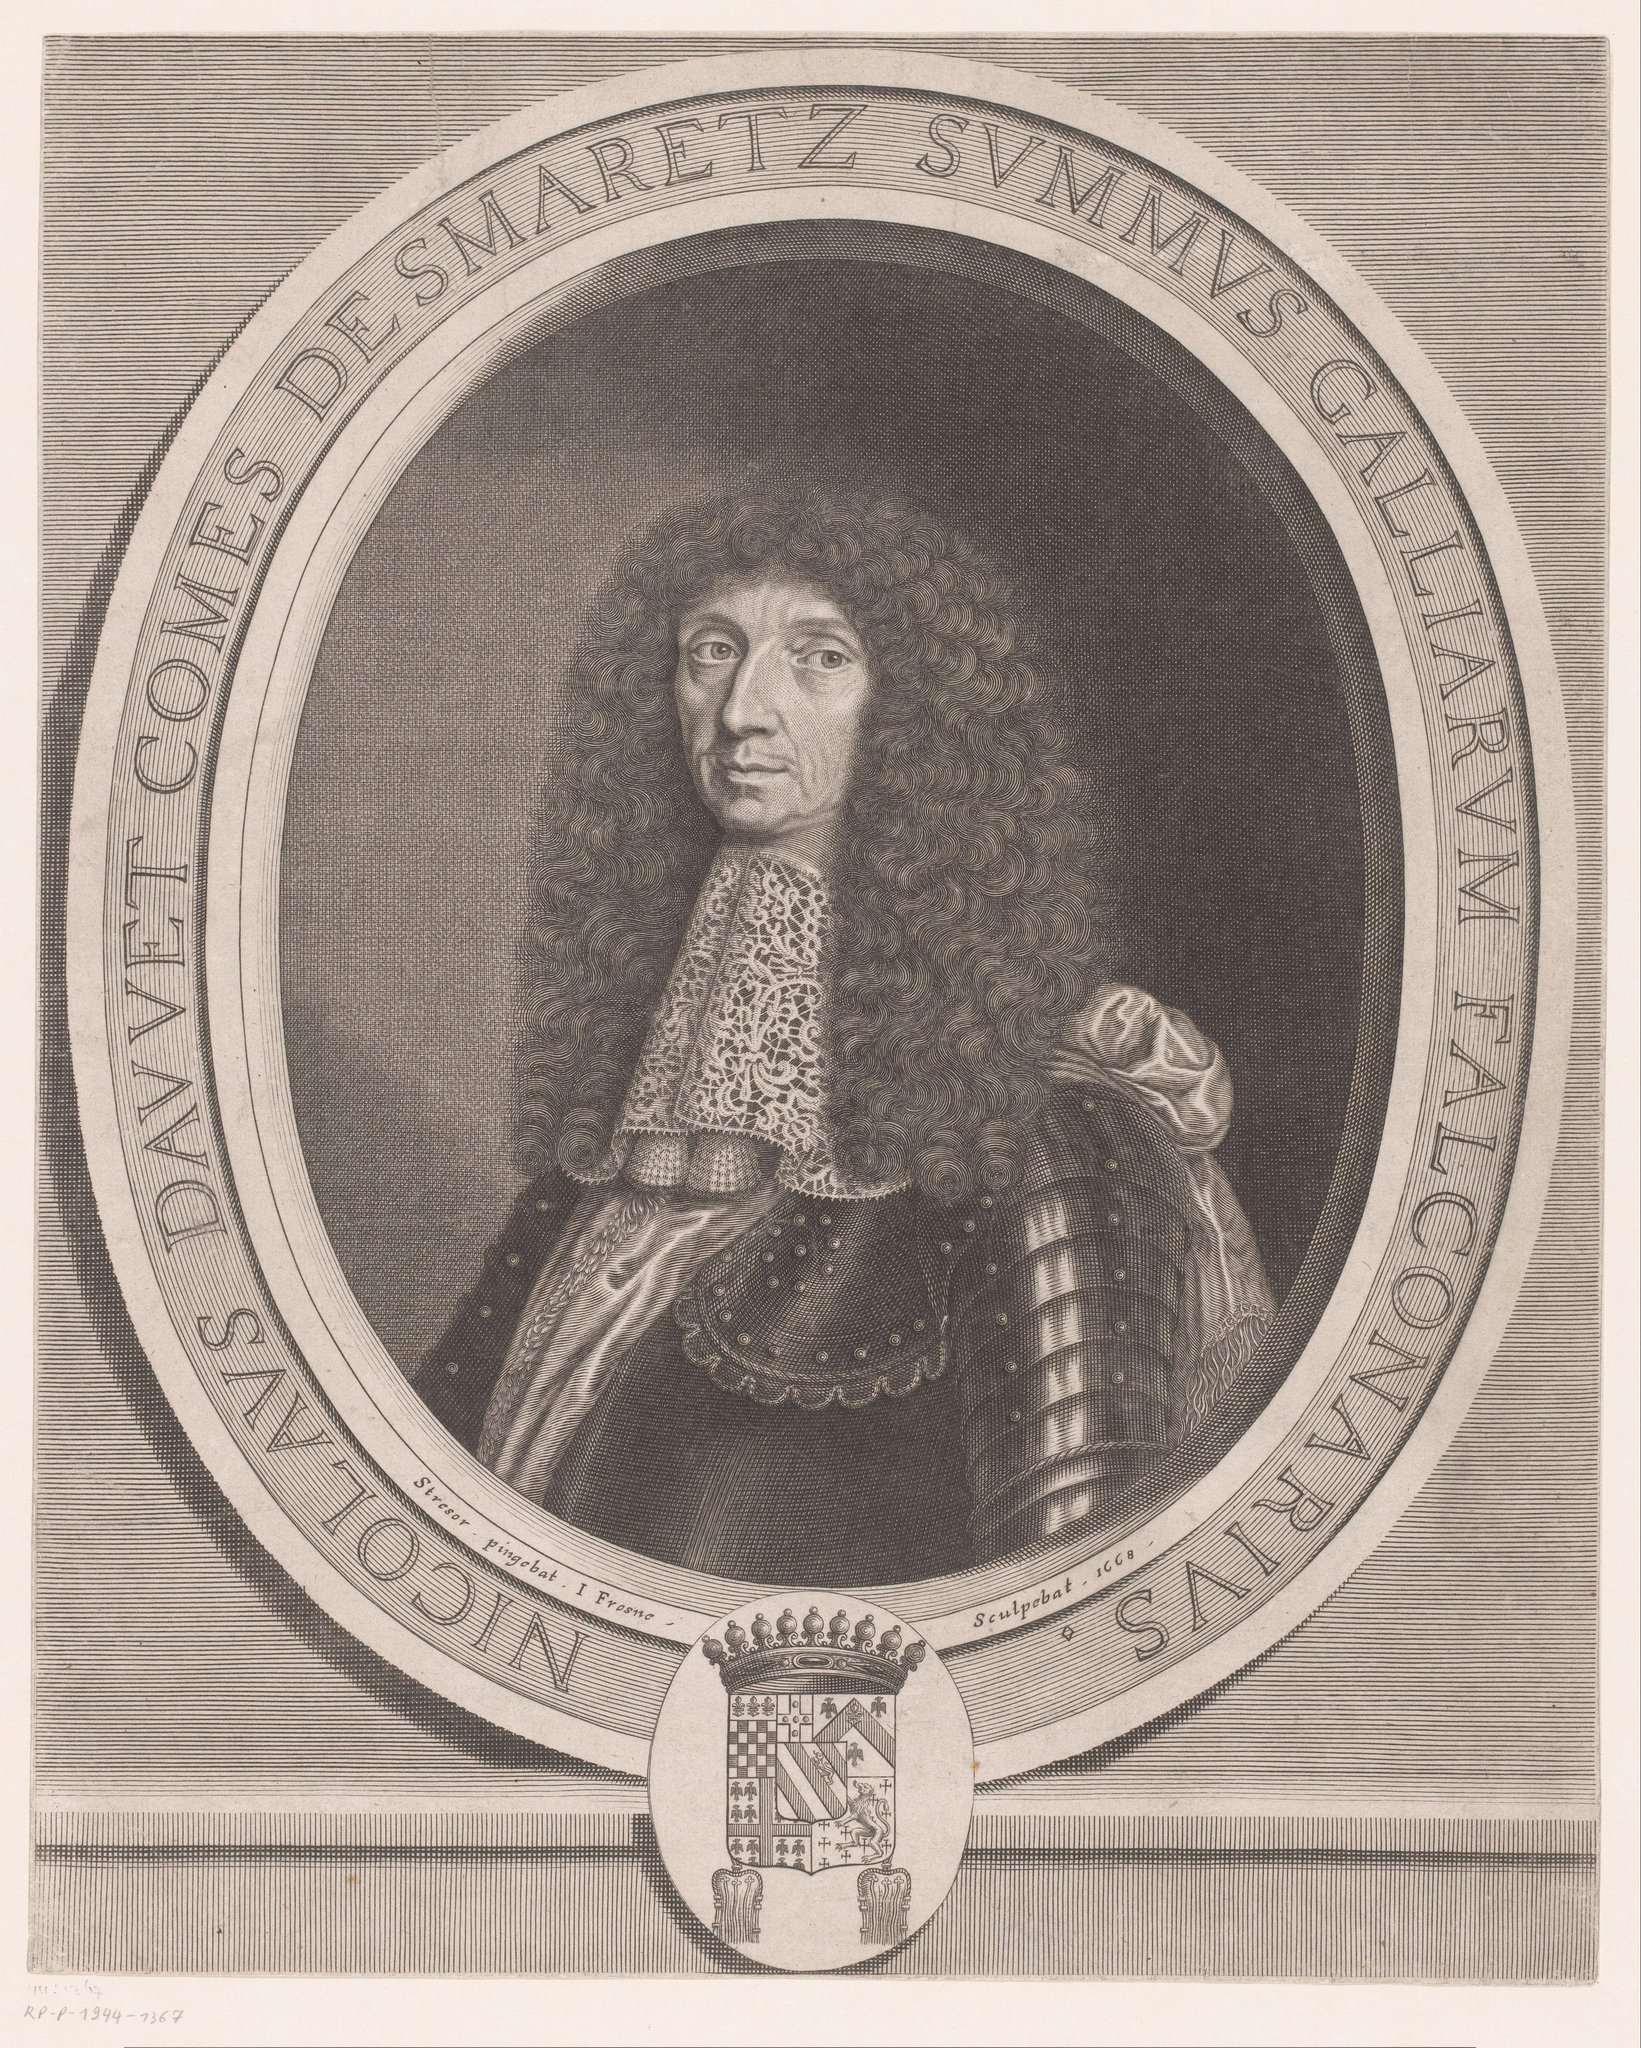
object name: print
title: Nicolaus Dauvet comes de Smaretz summus Galliarum Falconarius.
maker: jean frosne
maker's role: print maker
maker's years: 1623-1676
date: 1668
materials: paper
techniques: engraving, etching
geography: france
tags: ornament ~ medallion, historical persons, armorial bearing, heraldry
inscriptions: collector's mark: Lugt 2228